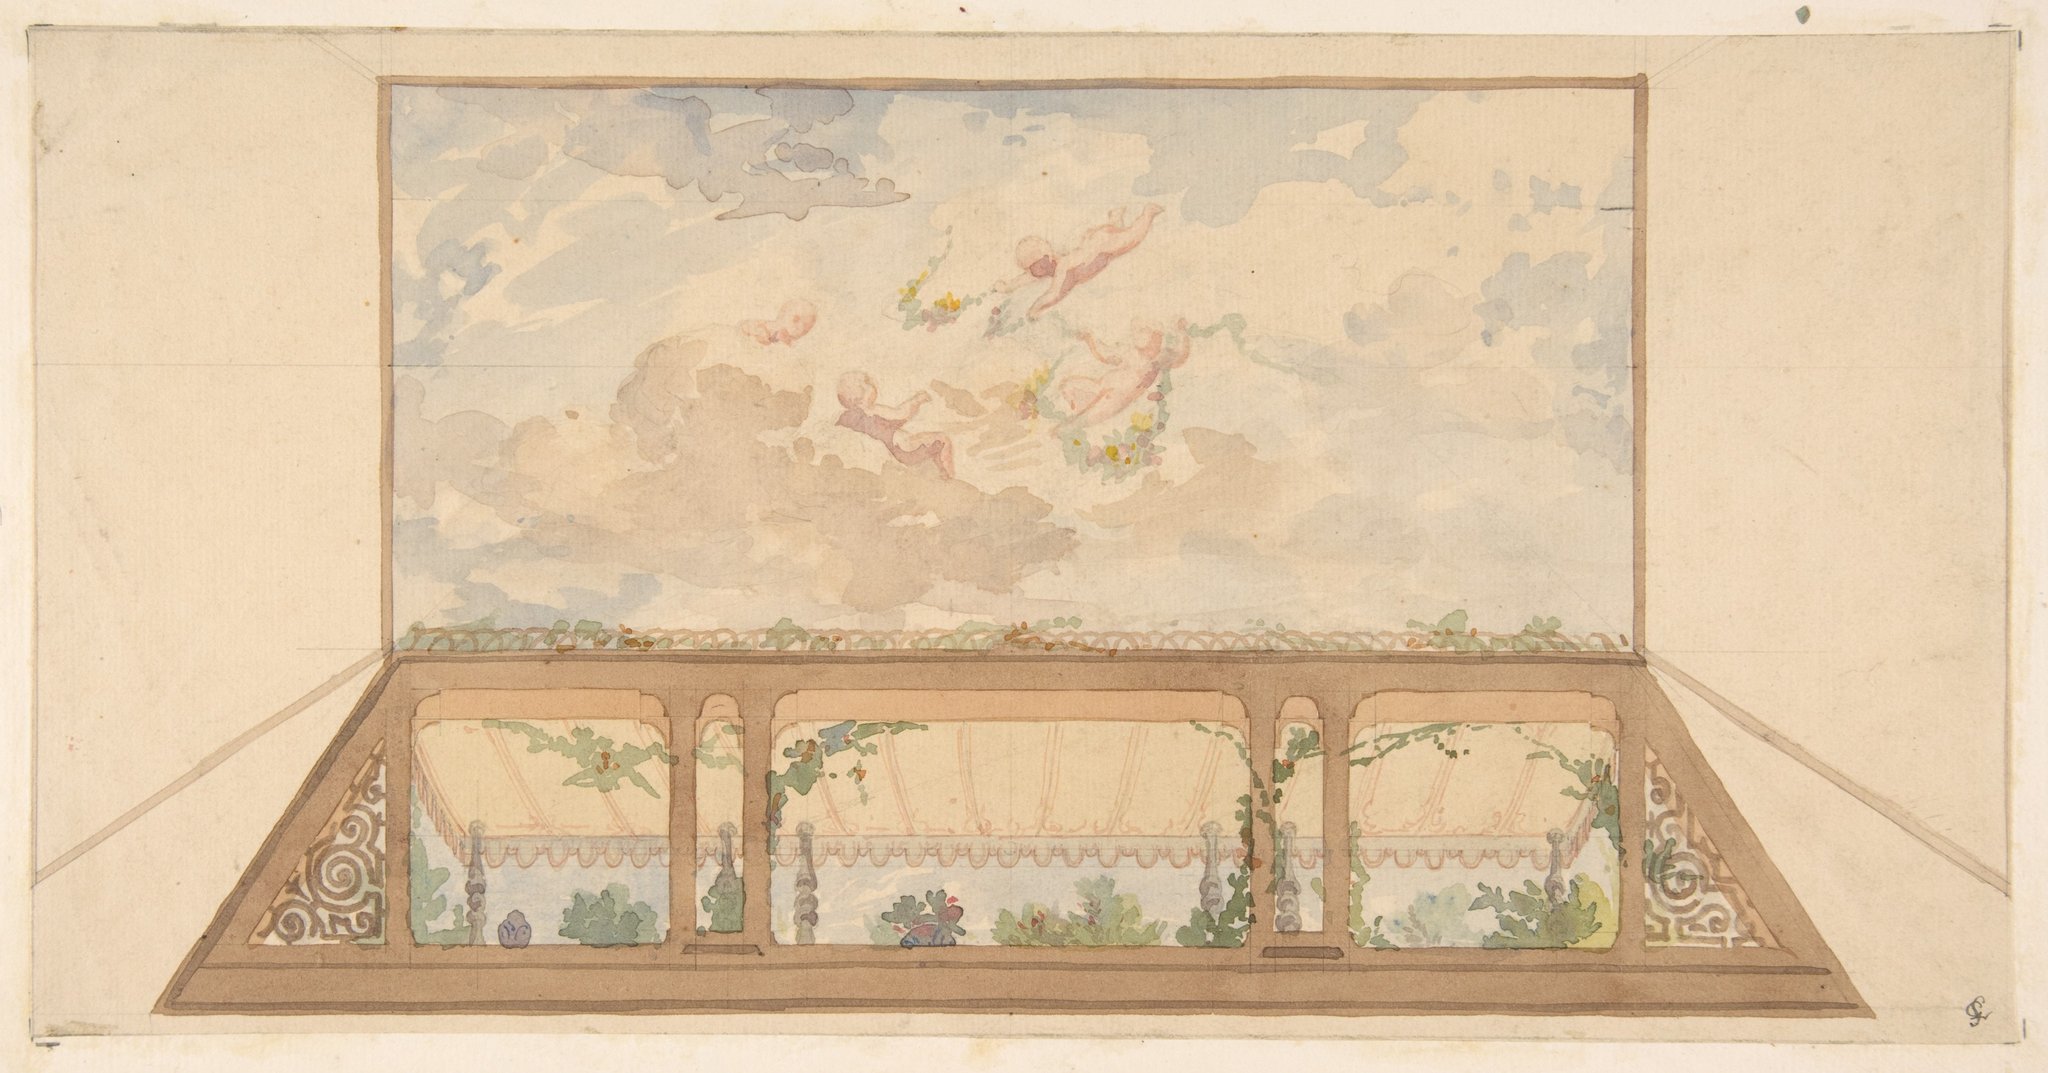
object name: drawing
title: Design for a ceiling painted with a trompe l'oeil awning and putti in clouds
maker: jules-edmond-charles lachaise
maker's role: artist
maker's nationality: french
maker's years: 1897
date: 1851-1900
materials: graphite, paper, watercolor